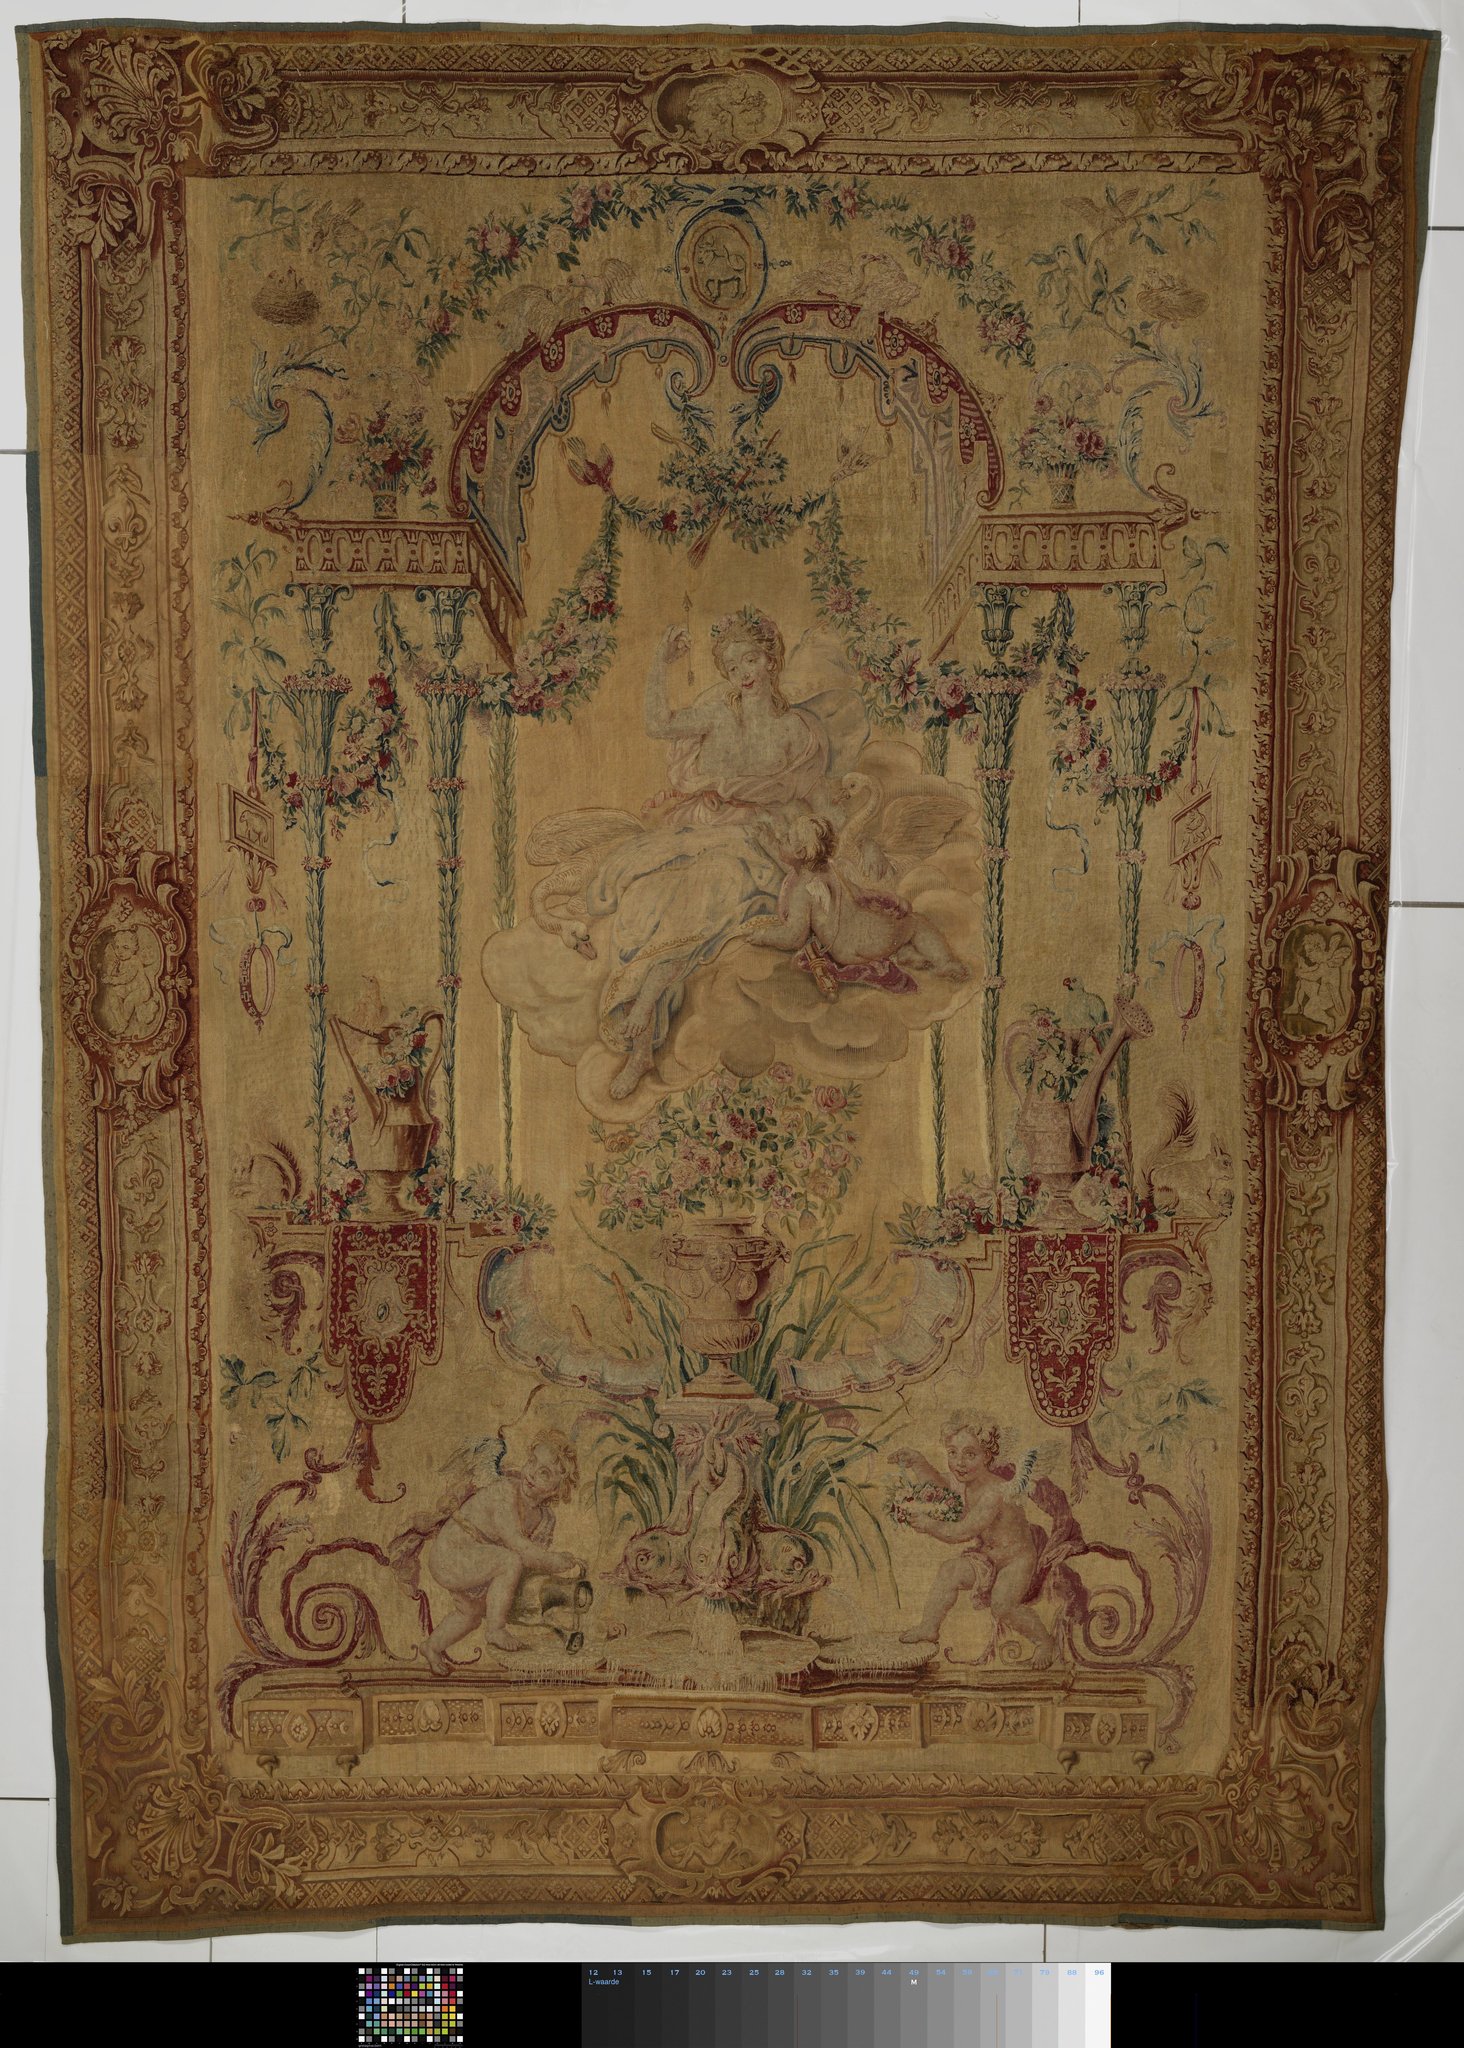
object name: portière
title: Tapestry Depicting Venus, Symbolizing Spring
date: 1699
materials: silk, wool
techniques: tapestry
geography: paris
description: Portière met Venus, als personificatie van de lente, omgeven door grotesken en het teken van Ram, Stier en Tweelingen, uit een serie van goden, seizoenen, elementen en tekens van de dierenriem.